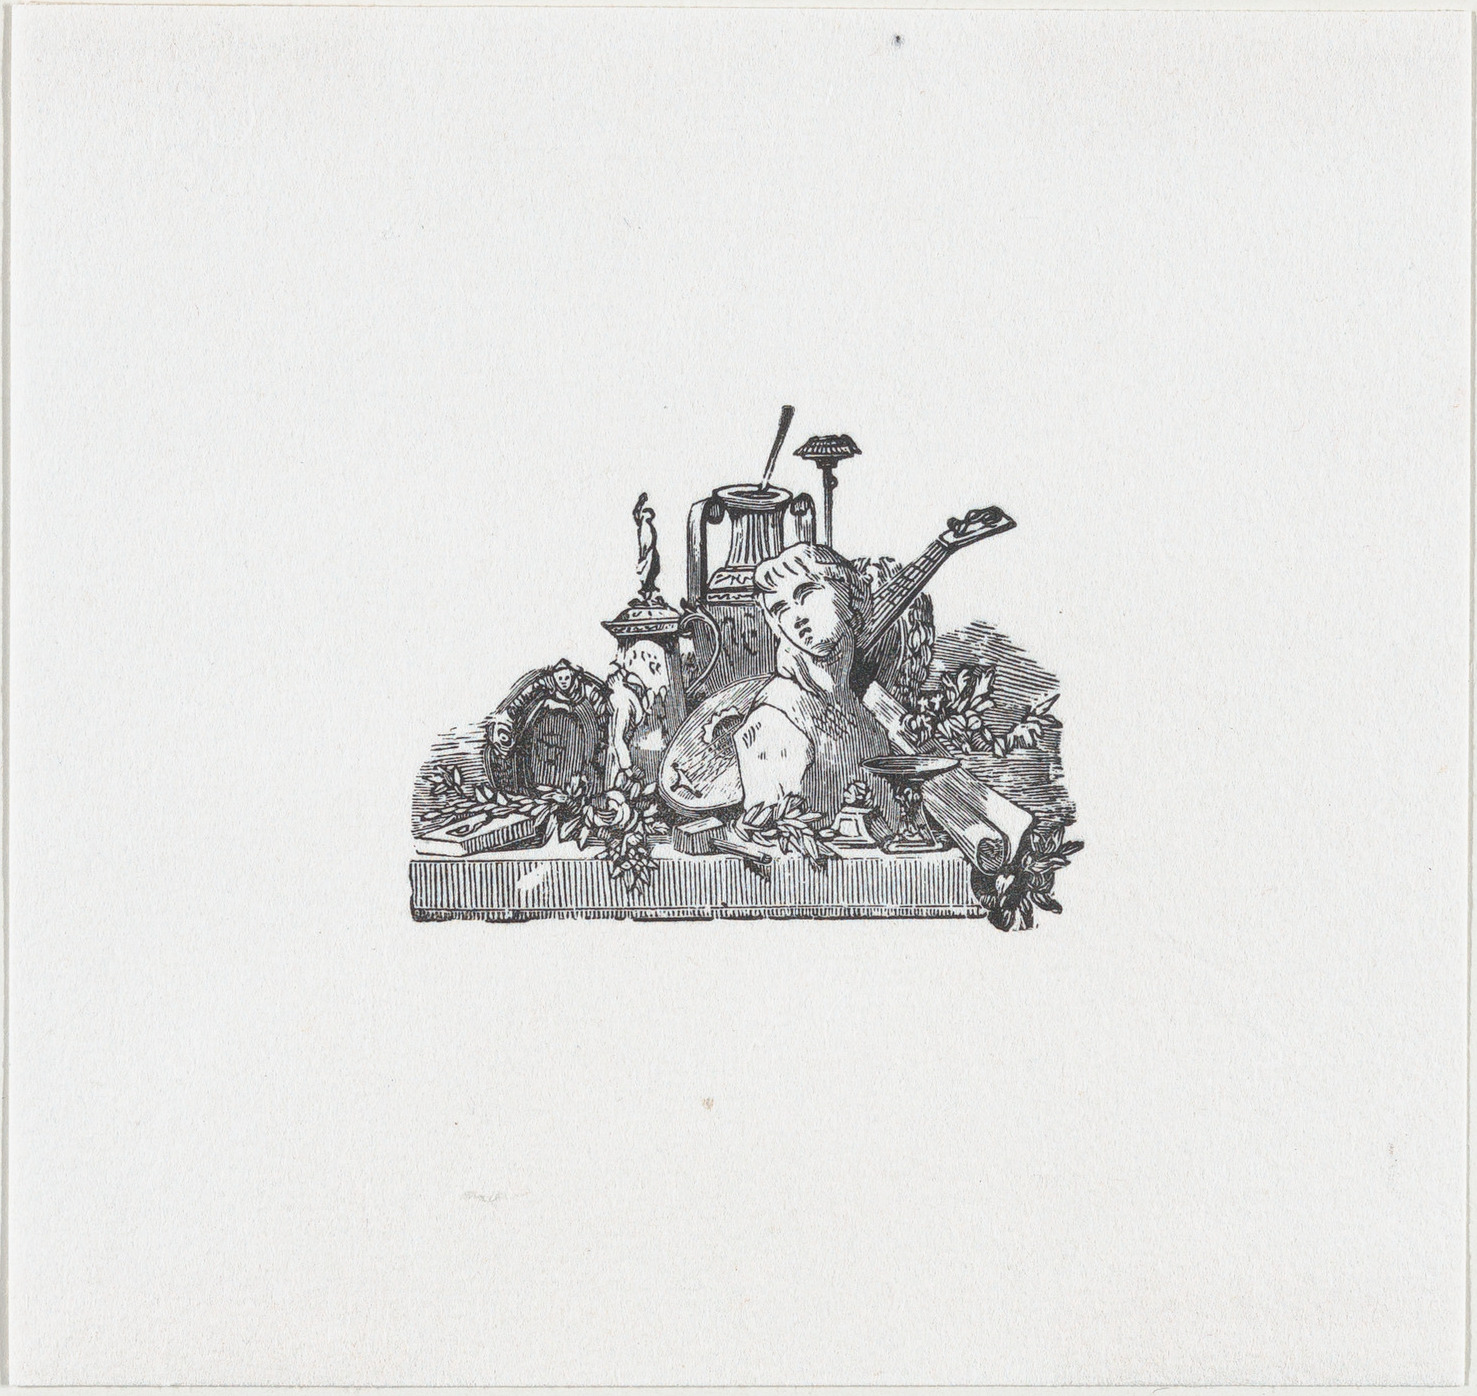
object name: print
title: Vignette of trophies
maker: anonymous, mexican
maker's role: artist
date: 1801-1900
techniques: engraving